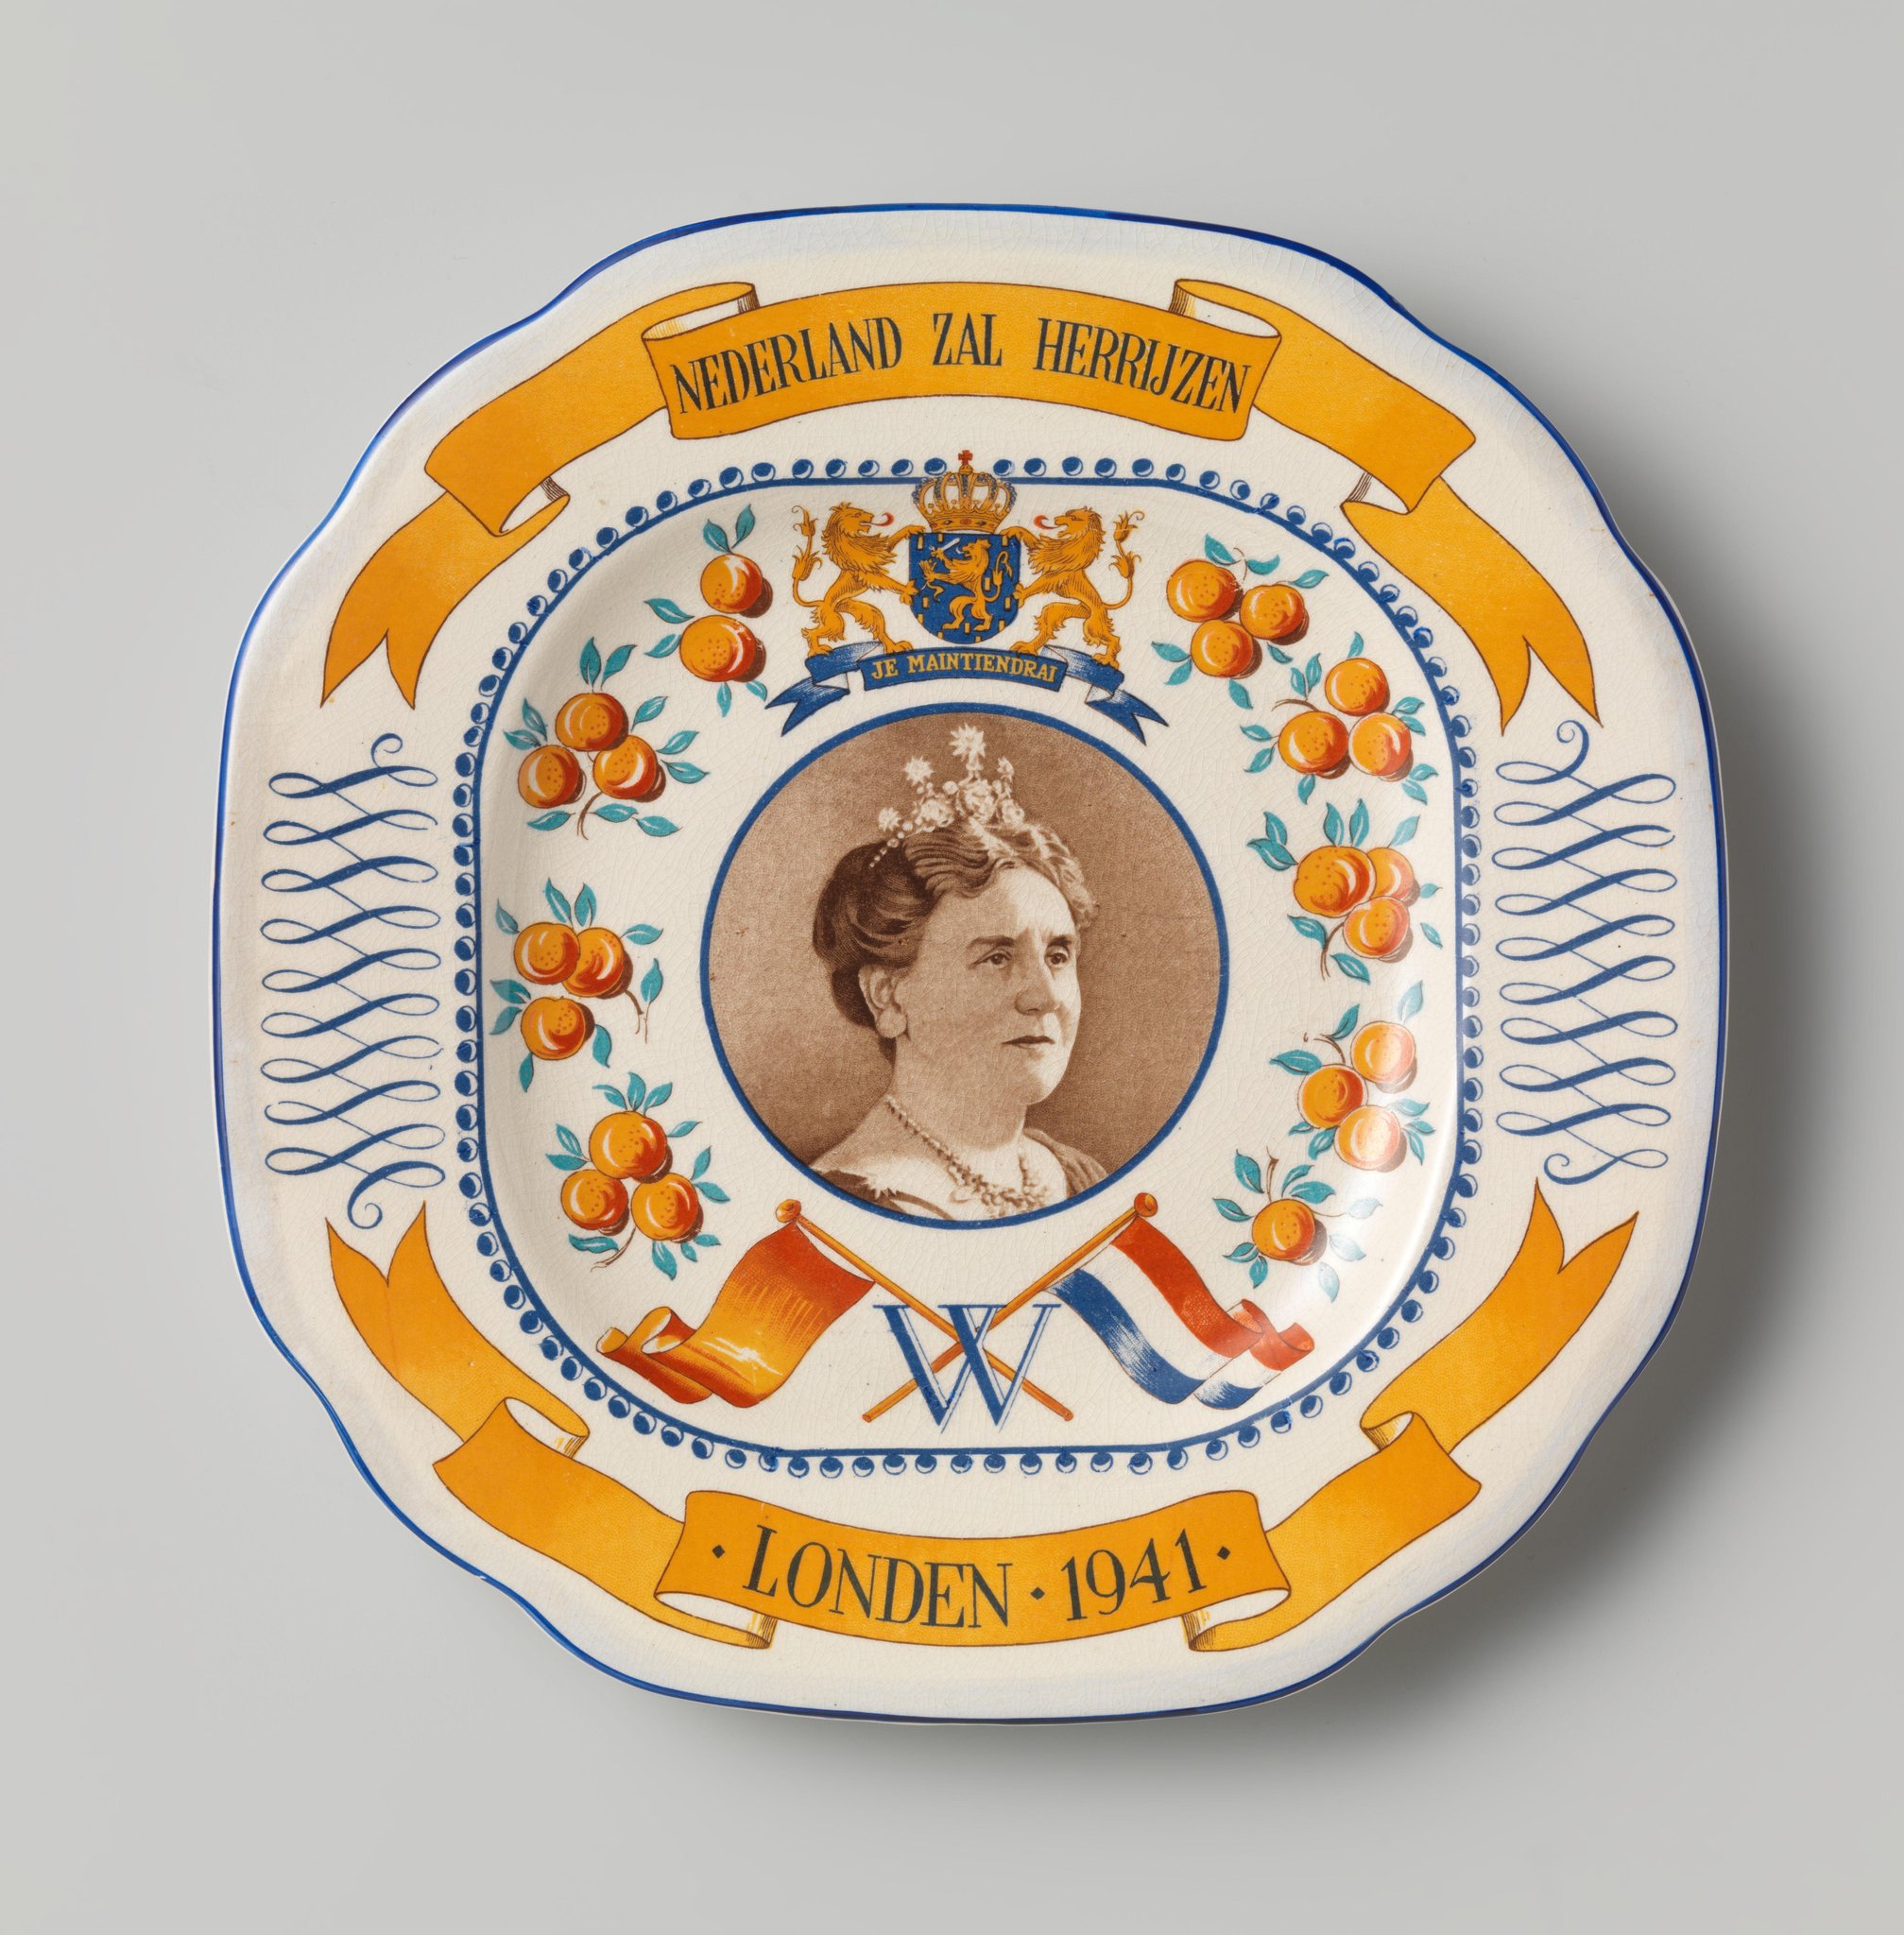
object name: plate dish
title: Bord met portret van Wilhelmina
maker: Anonymous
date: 1941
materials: ceramic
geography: england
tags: the hague, wilhelmina frederica louisa (koningin der nederlanden)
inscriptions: : ‘SILICON CHINA / MADE IN ENGLAND / PROV. REG. No. 839140 / LONDON . COMMITTEE . NETHERLANDS . RED . CROSS / WELFARE . COMMITTEE . NETH . FIGHTING . FORCES / NETHERLANDS . EMERGENCY . COMMITTEE’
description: Bord met portret van Wilhelmina. Op de rand van het bord staat in twee oranje banderols 'NEDERLAND ZAL HERRIJZEN / .LONDEN.1941.'. Centraal een ronde foto van Wilhelmina. Aan de achterzijde zit een metaaldraad met groen kunststof omhuld om het bord aan te kunnen ophangen.